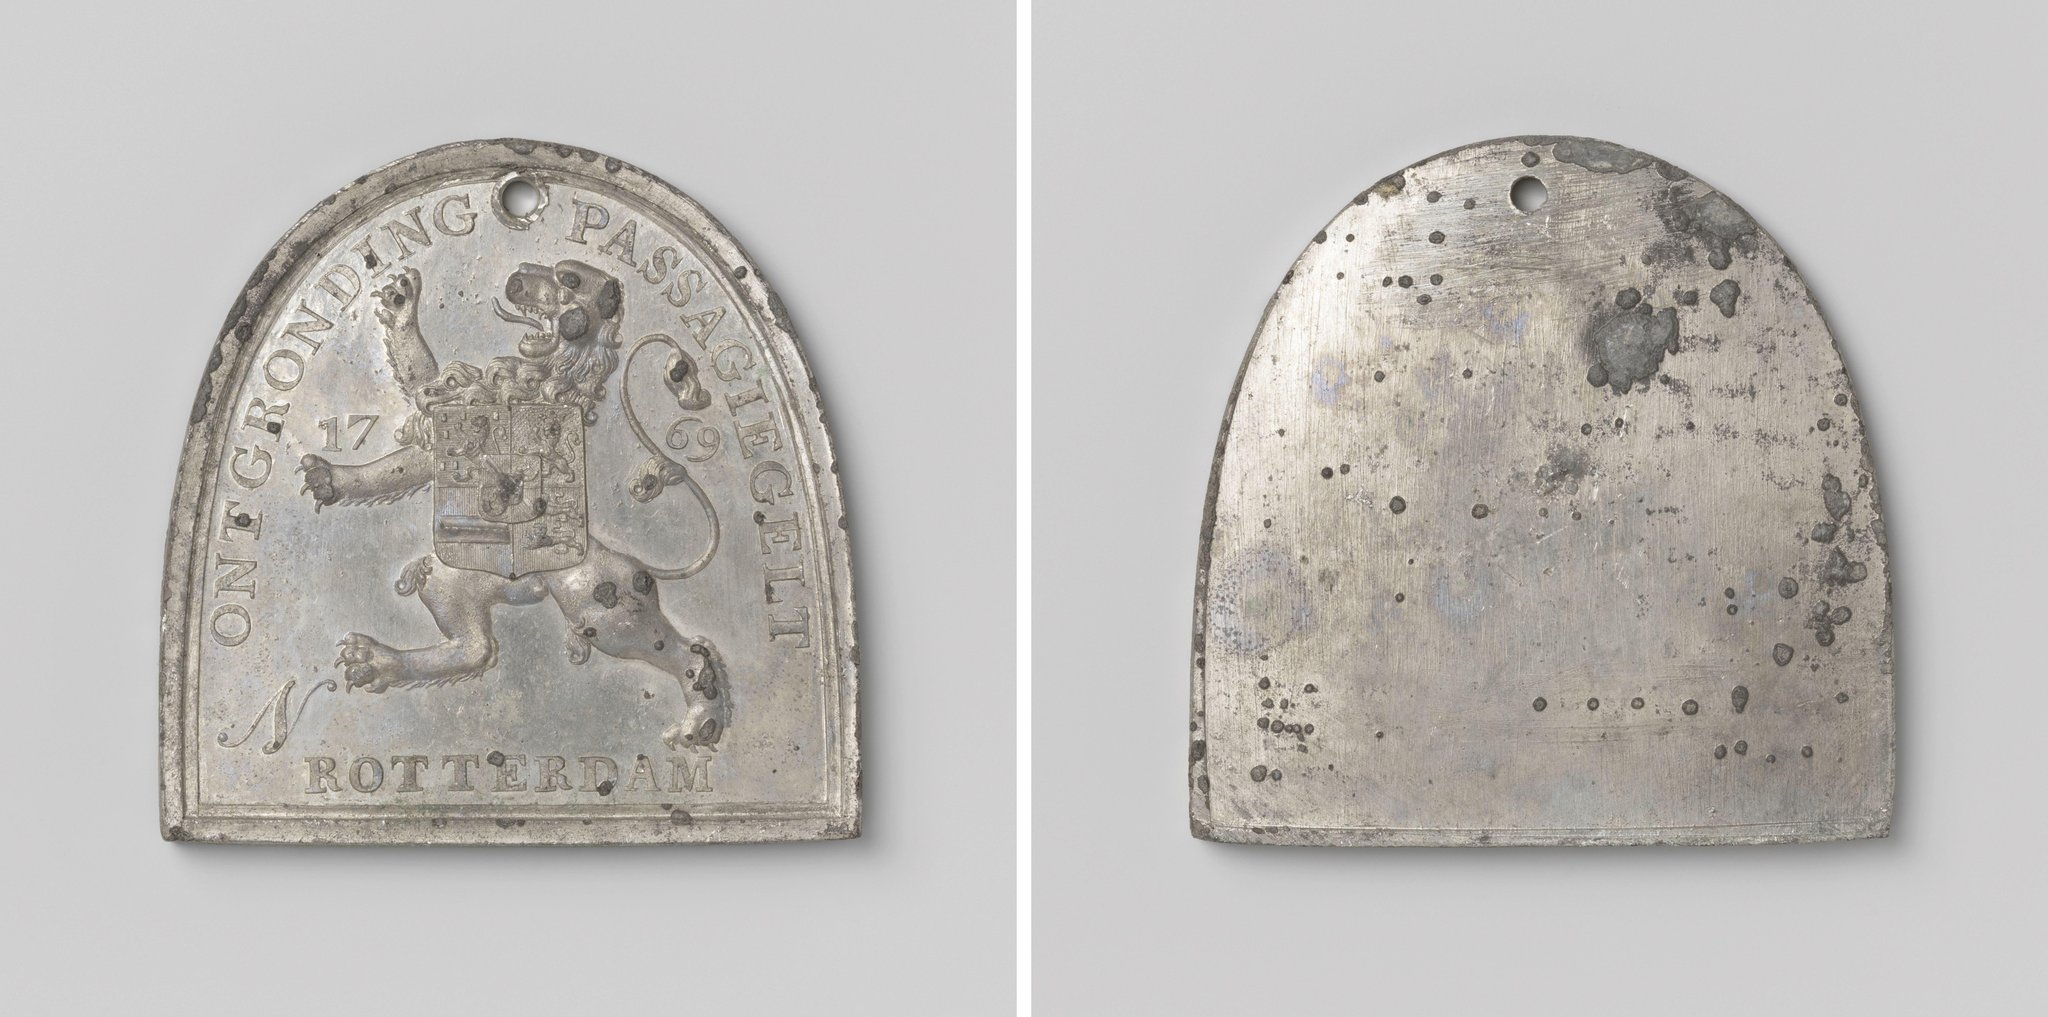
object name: ontgrondingspenning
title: Ontgronding te Rotterdam, penning bedoeld als bewijs voor turfdragers, -vullers of -tonners om turf in te mogen voeren uit de nieuw ontgronde venen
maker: Anonymous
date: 1769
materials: lead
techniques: casting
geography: rotterdam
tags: rotterdam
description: Eenzijdige loden penning met ronde boven- en rechthoekige onderzijde, en gat erin. Voorzijde: staande leeuw met wapenschild op borst tussen jaartal binnen omschrift. Keerzijde: blanco.